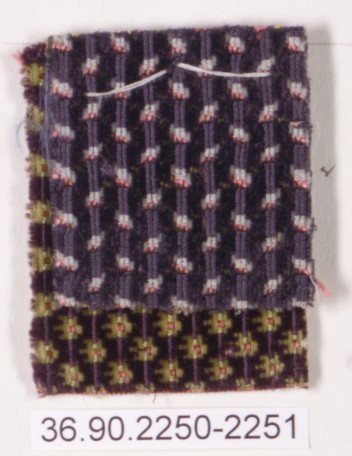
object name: piece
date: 1801-1900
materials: silk